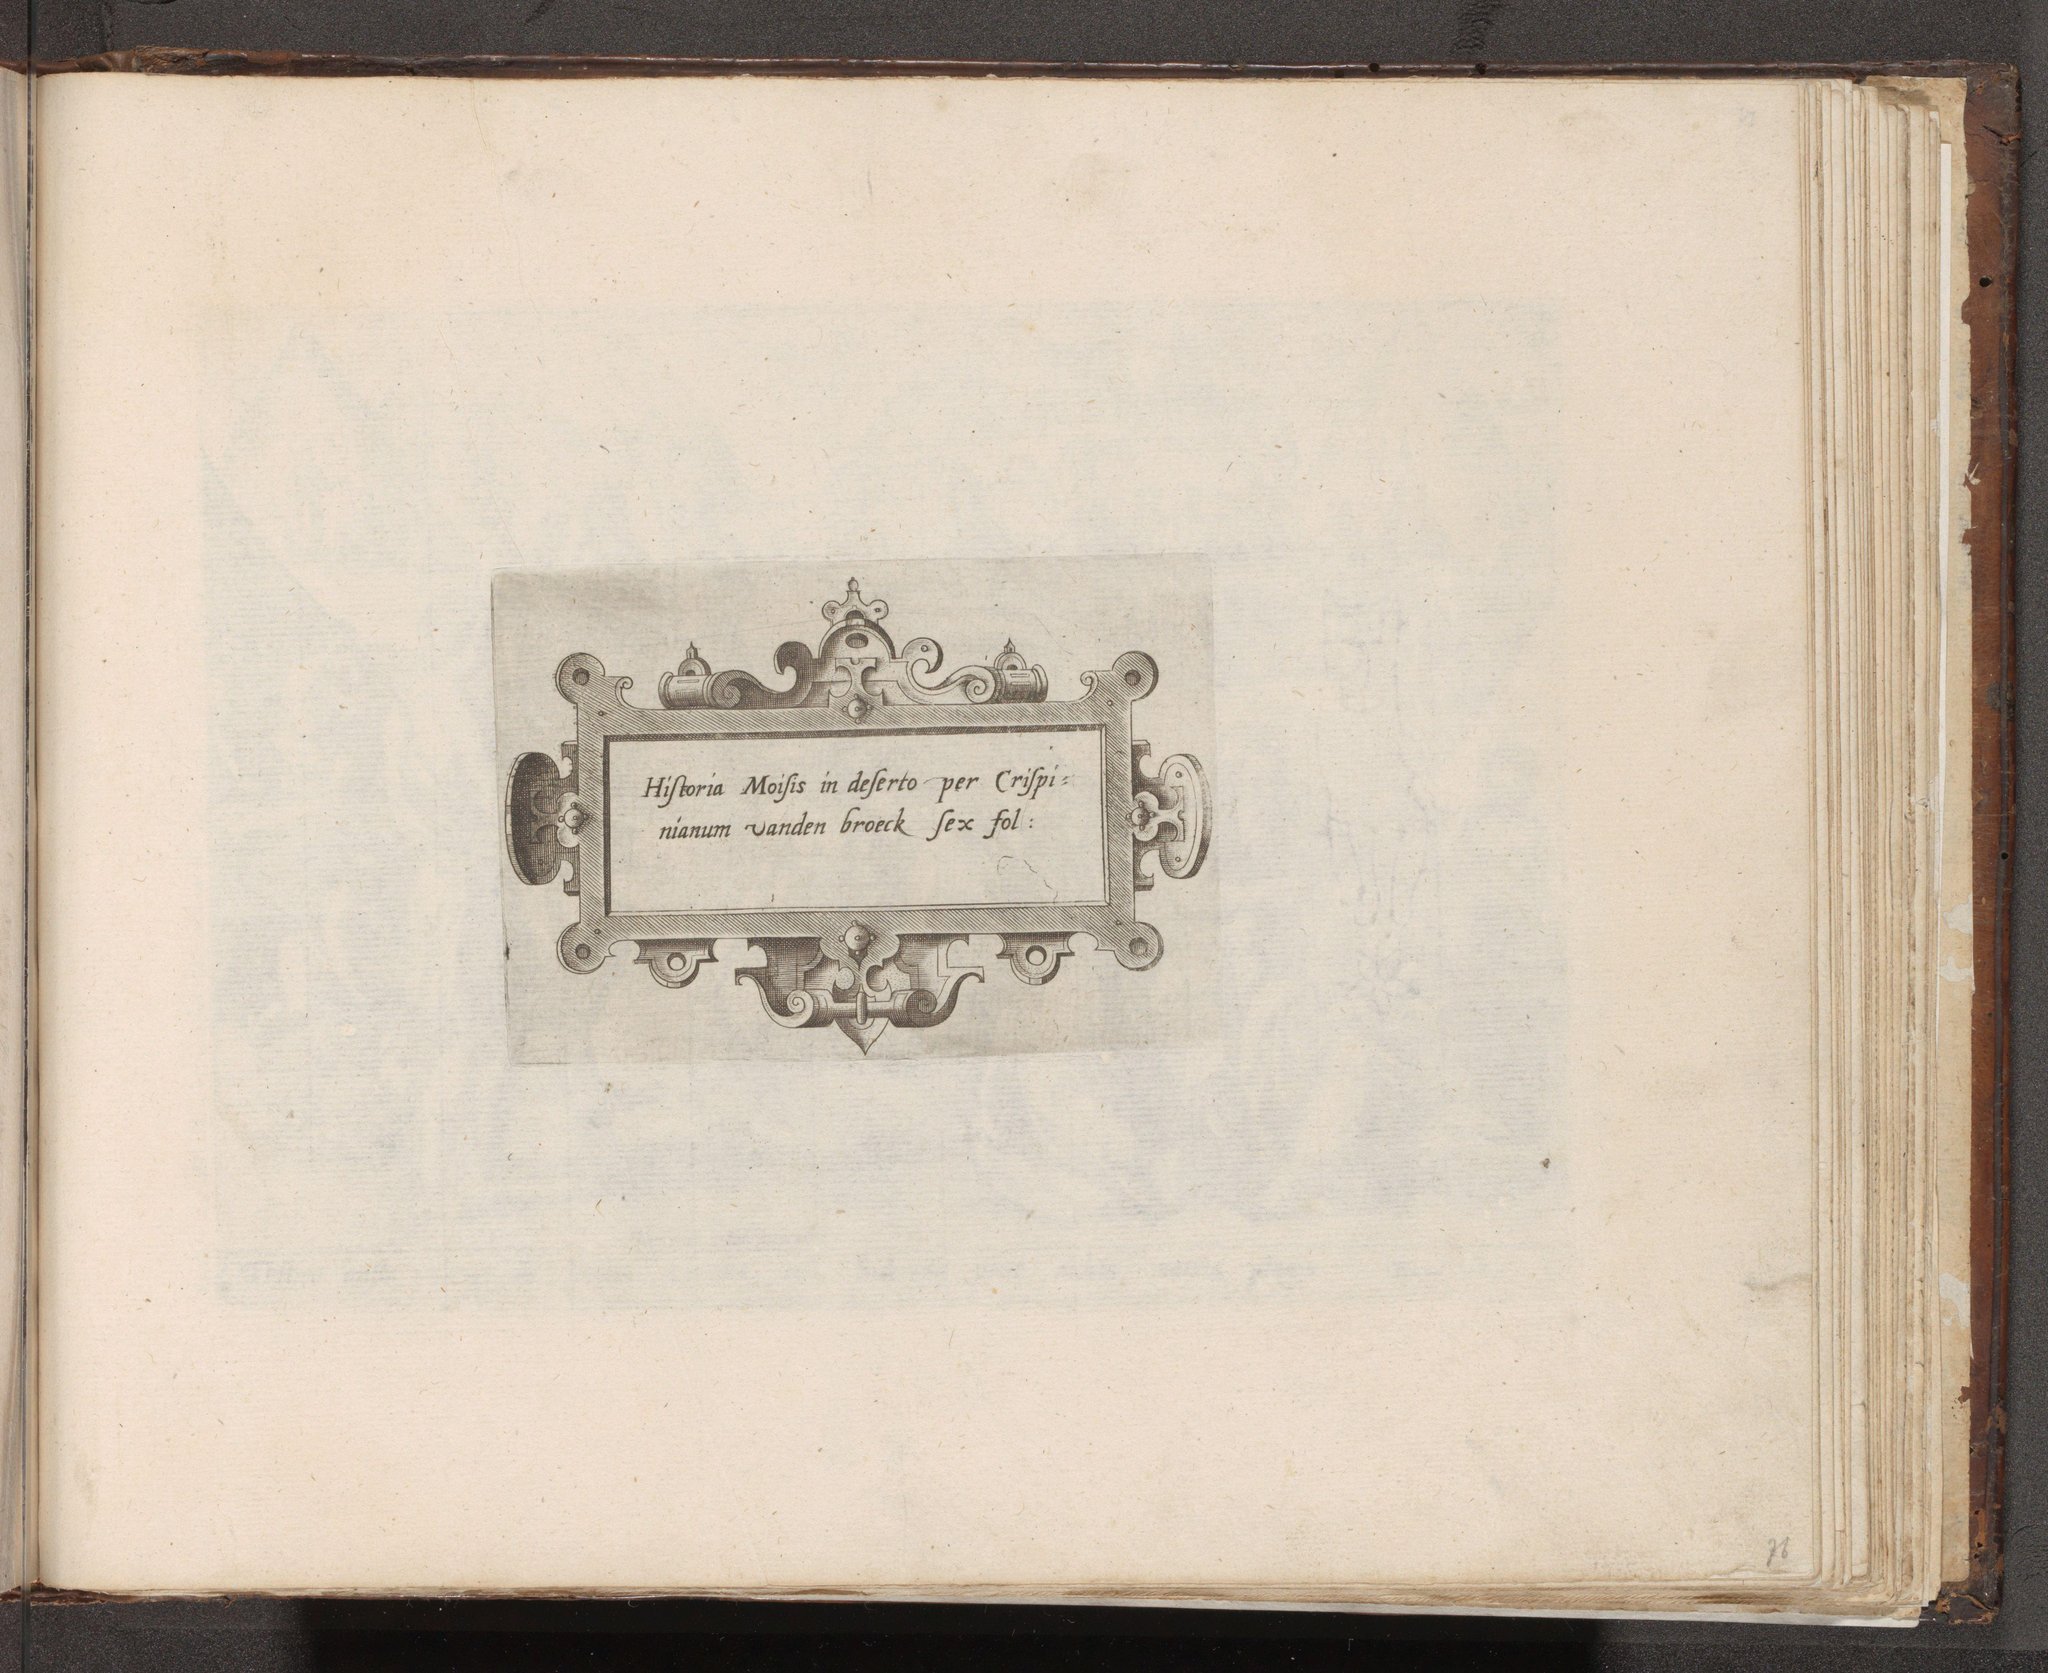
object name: album leaf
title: Thesaurus sacrarum historiaru[m] veteris testame[n]ti, elega[n]tissimis imaginibus expressu[m] excelle[n]tissimoru[m] in hac arte viroru[m] opera: nu[n]c primu[m] in luce[m] editus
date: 1579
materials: paper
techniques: engraving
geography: antwerp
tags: scrollwork, strapwork ~ ornament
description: Titel in cartouche met rolwerk. Titelprent voor een serie prenten over de geschiedenis van Mozes na de Exodus. Prent maakt deel uit van een album.